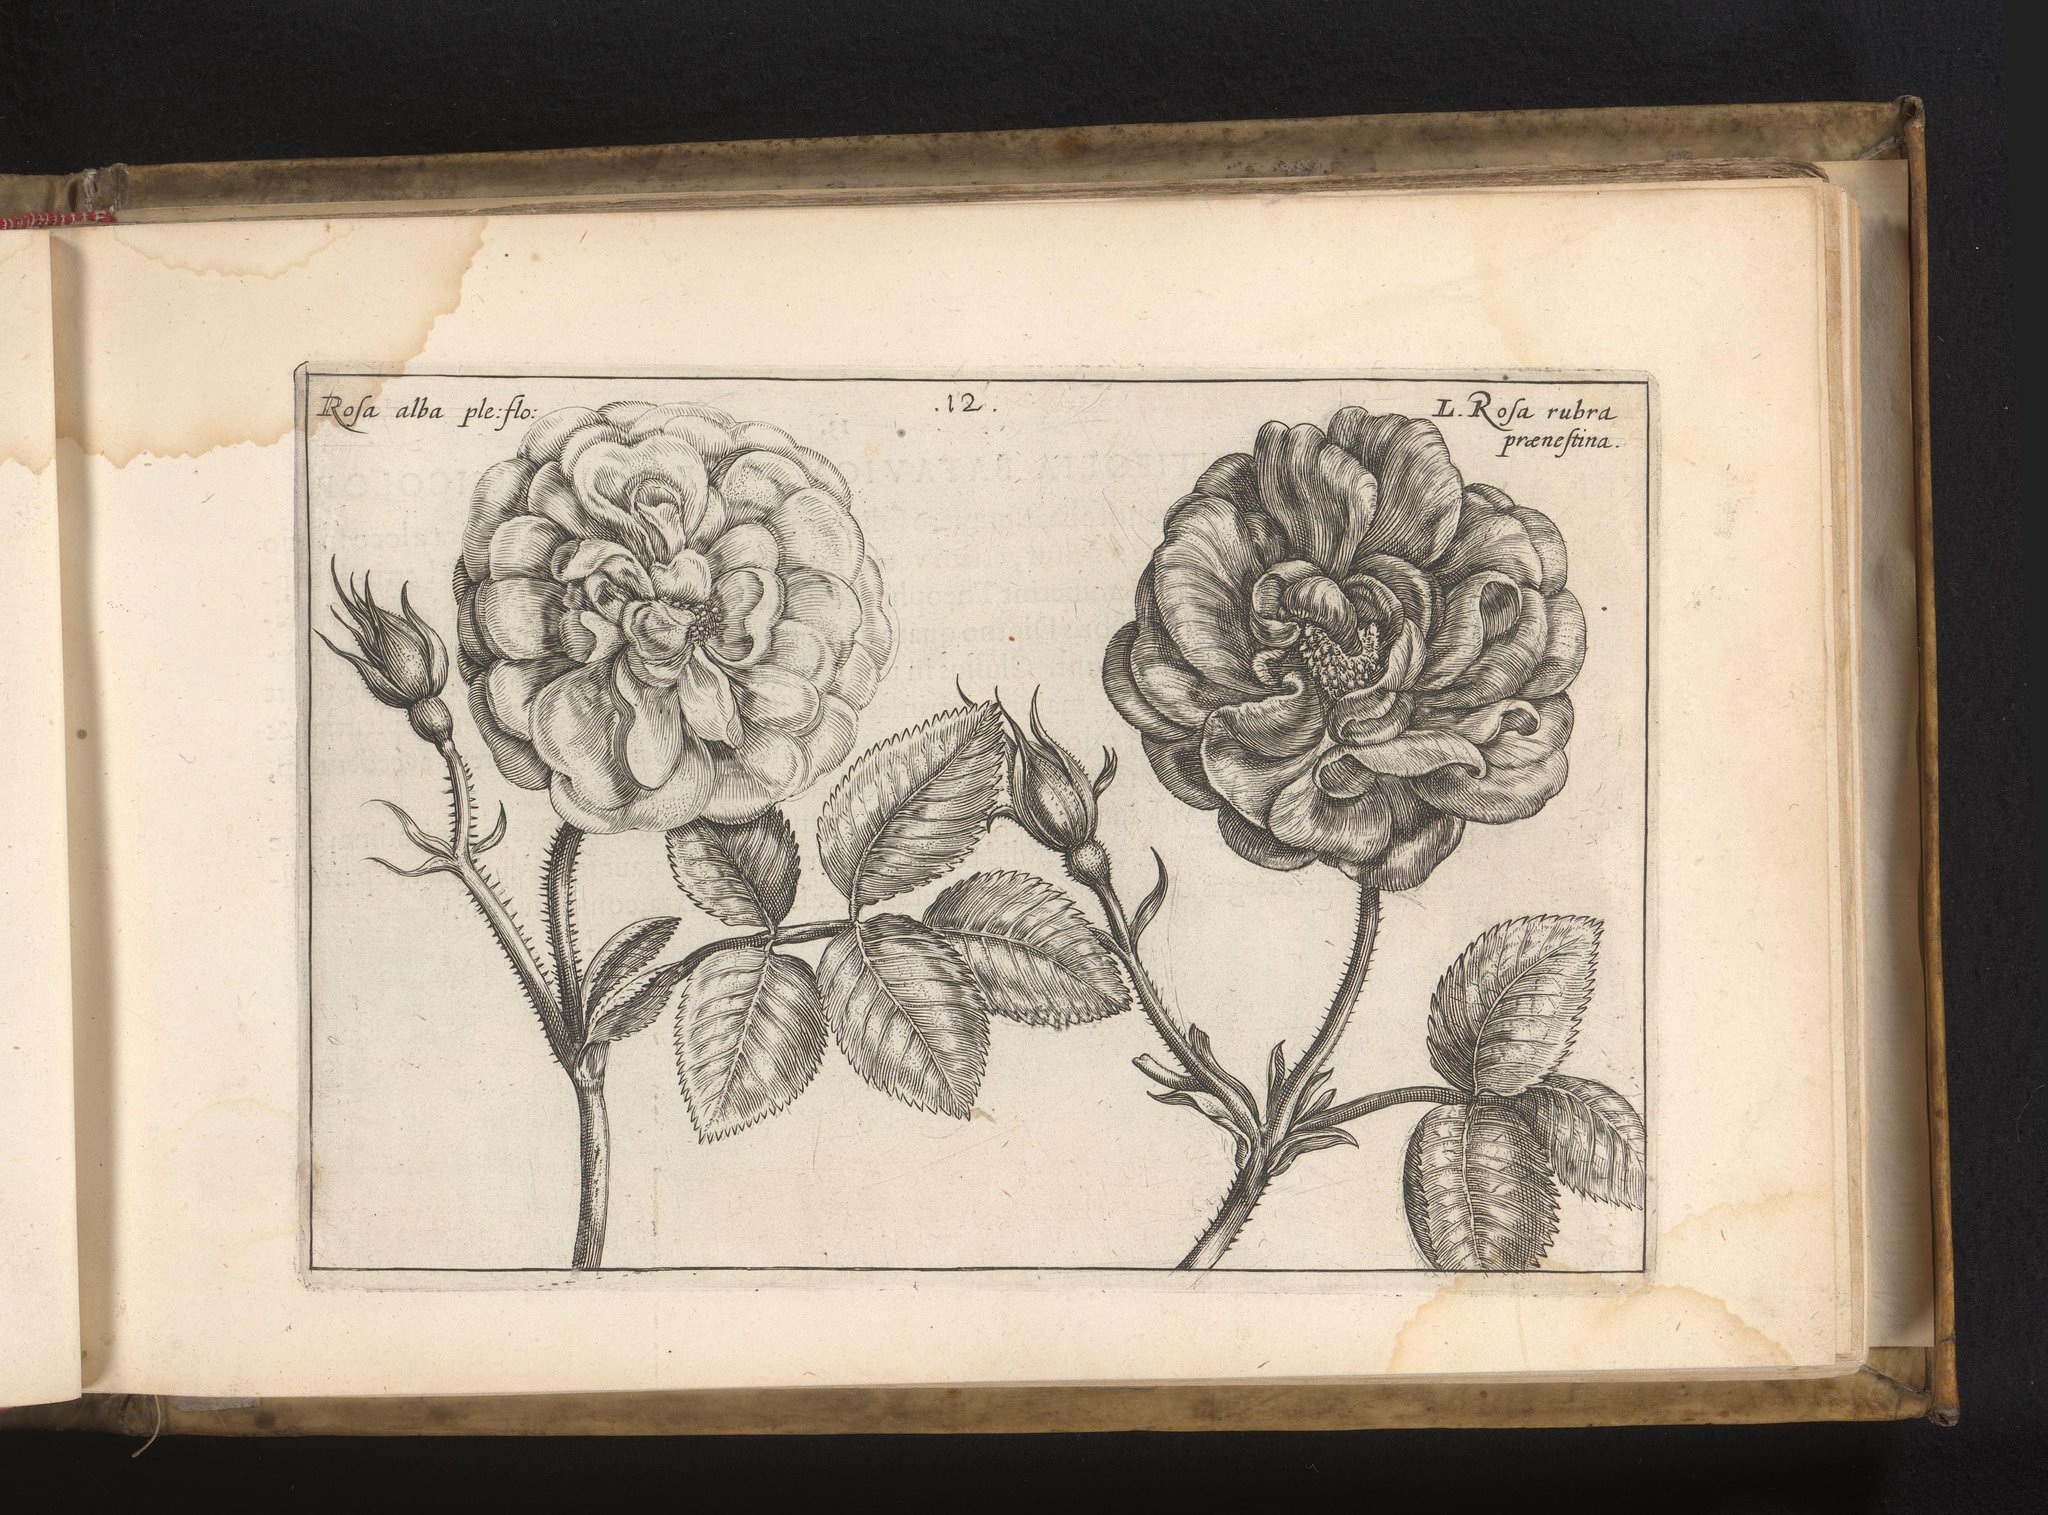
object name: page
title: Rosa alba ple. flo.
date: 1617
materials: paper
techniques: engraving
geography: utrecht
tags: flowers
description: Prent uit: Passe, Crispijn van de (II). Hortus floridus in quo rariorum & minus vulgarium florum icones ad vivam veramque formam. Arnhem: Johannes Janssonius, 1617.